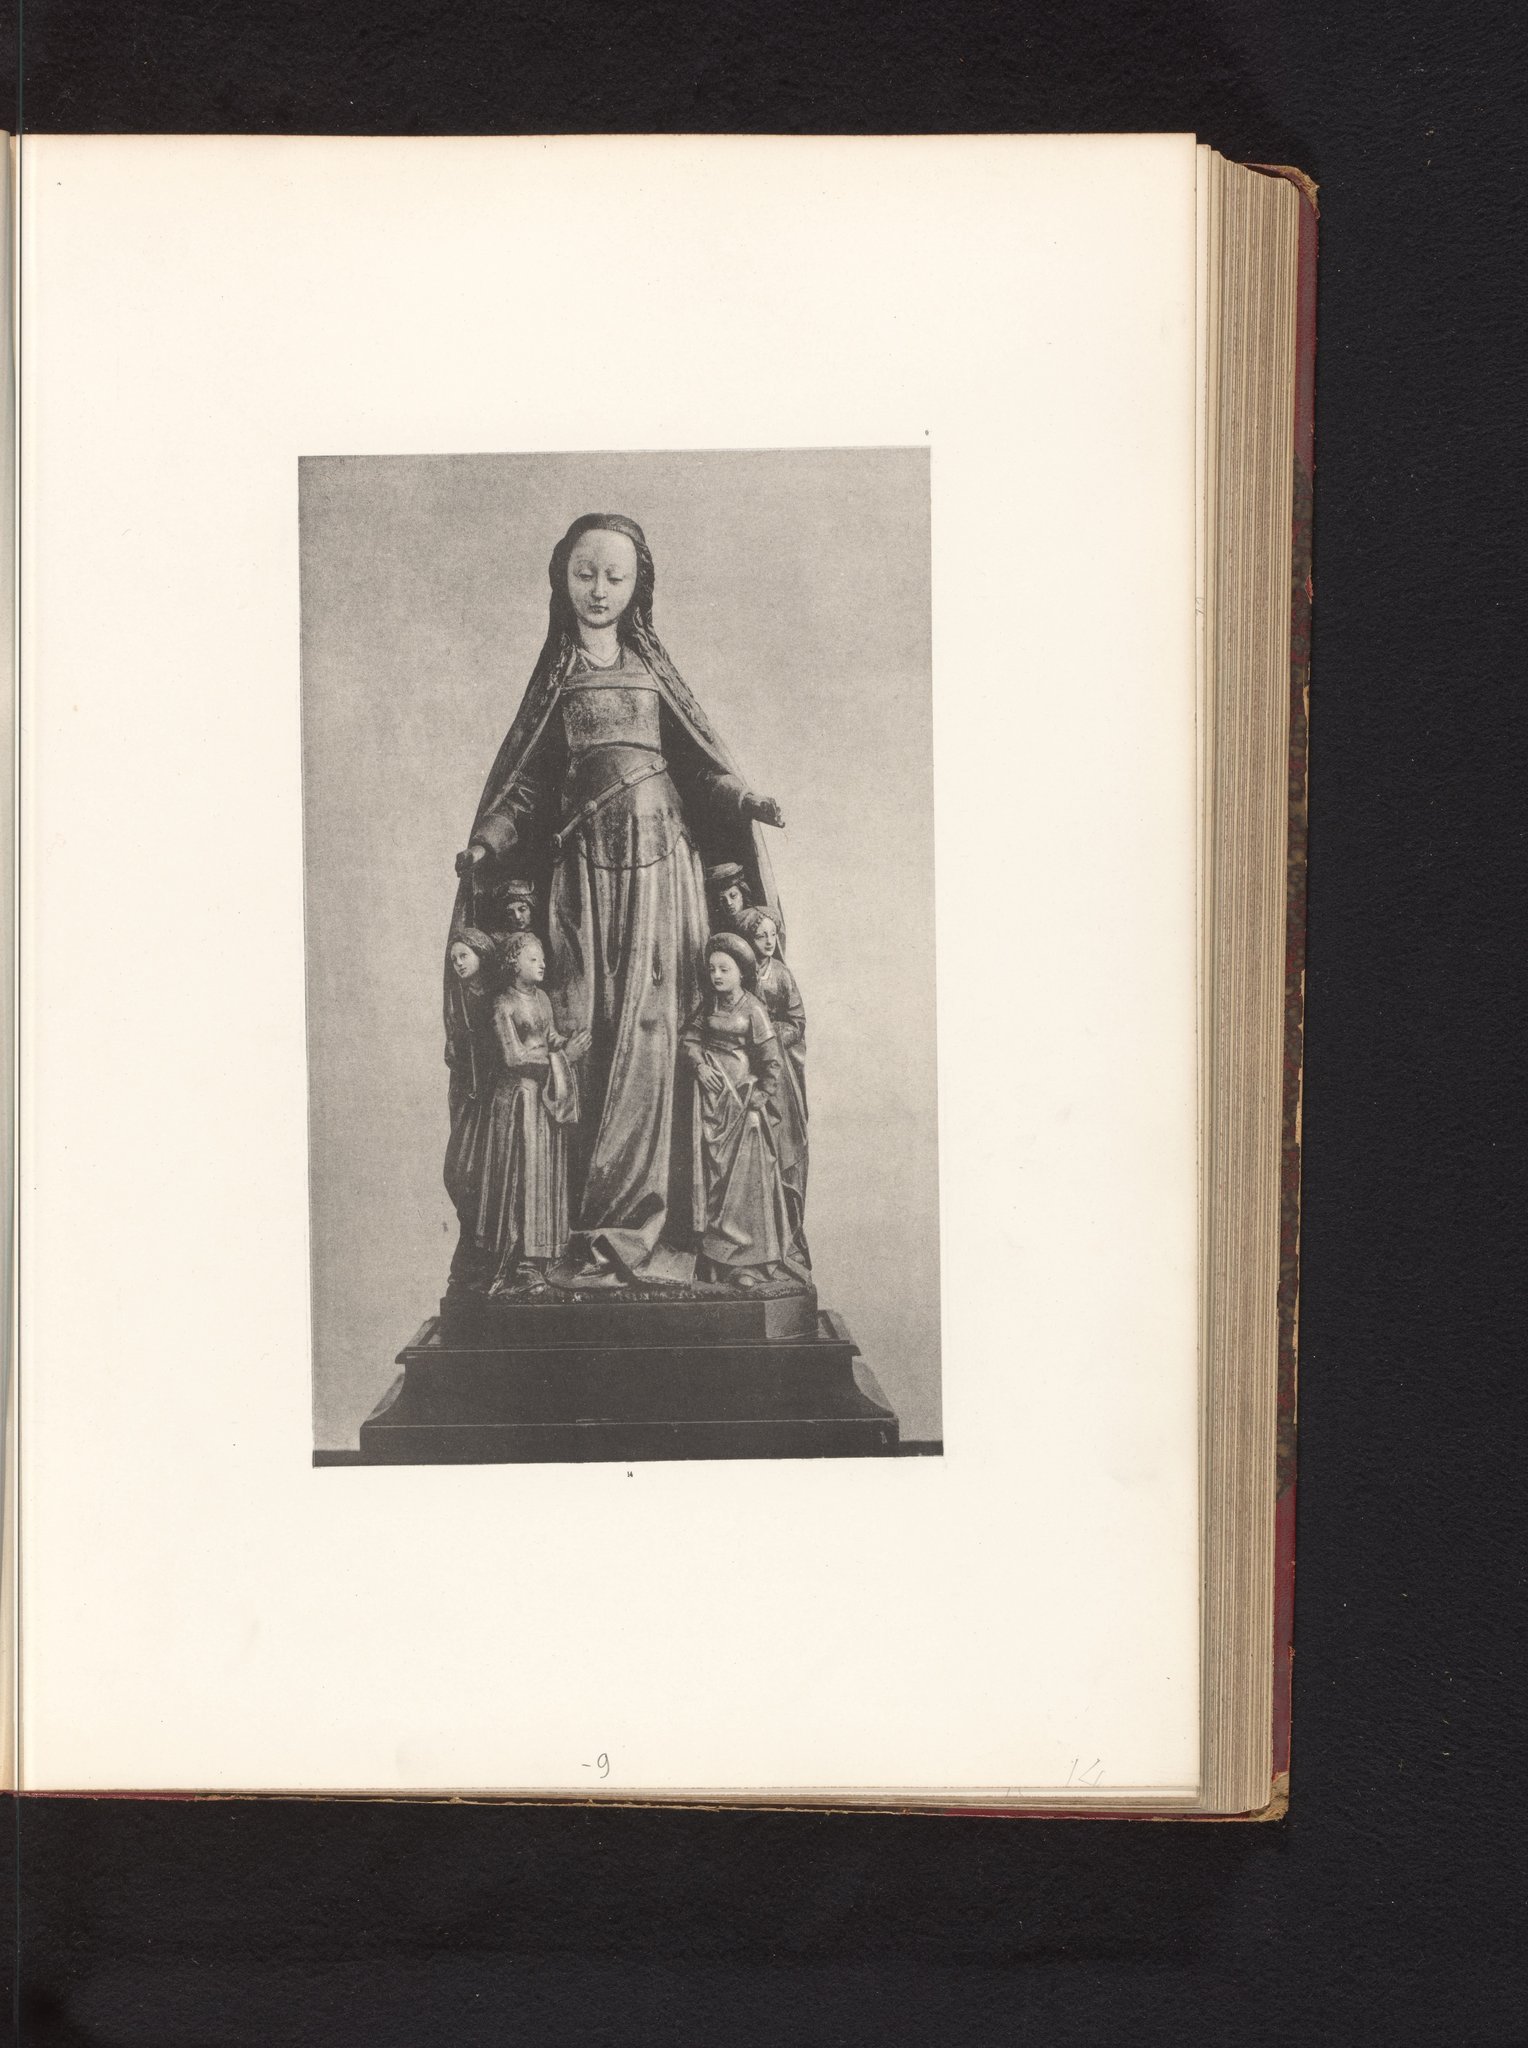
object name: page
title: Sculptuur van gekleurd eikenhout van Maria die monniken en nonnen onder haar mantel verstopt, opgesteld op een tentoonstelling over religieuze objecten uit de middeleeuwen en renaissance in 1864 in Mechelen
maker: joseph maes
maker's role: fotograaf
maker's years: 1838-1908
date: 1864-1866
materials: paper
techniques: photolithography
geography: antwerp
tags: piece of sculpture, reproduction of a piece of sculpture (+ wood, e.g.: panel ~ arts), mother of mercy, 'mater misericordiae', 'schutzmantelmadonna', 'schutzmantelmaria', mechelen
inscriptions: number: ‘14’, number: ‘14’, number: ‘-9’